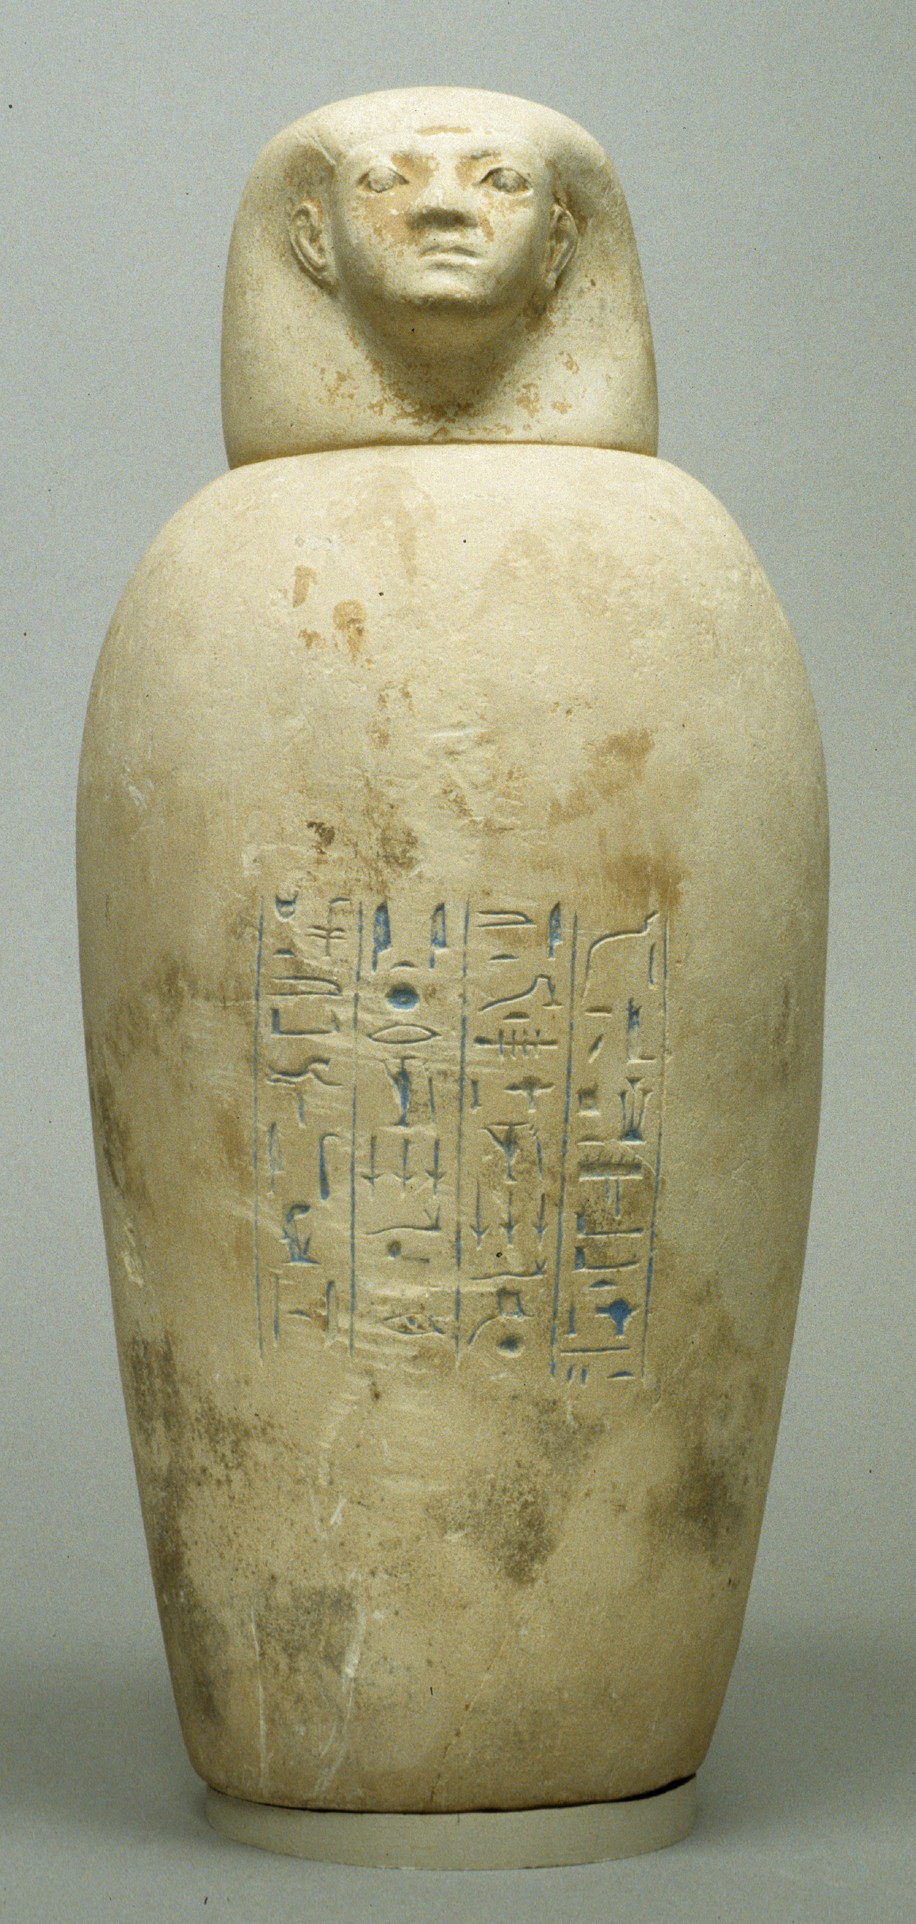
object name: canopic jar, maruta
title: Canopic Jar of Maruta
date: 1479-1425 BCE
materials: limestone, paste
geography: egypt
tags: hieroglyphs